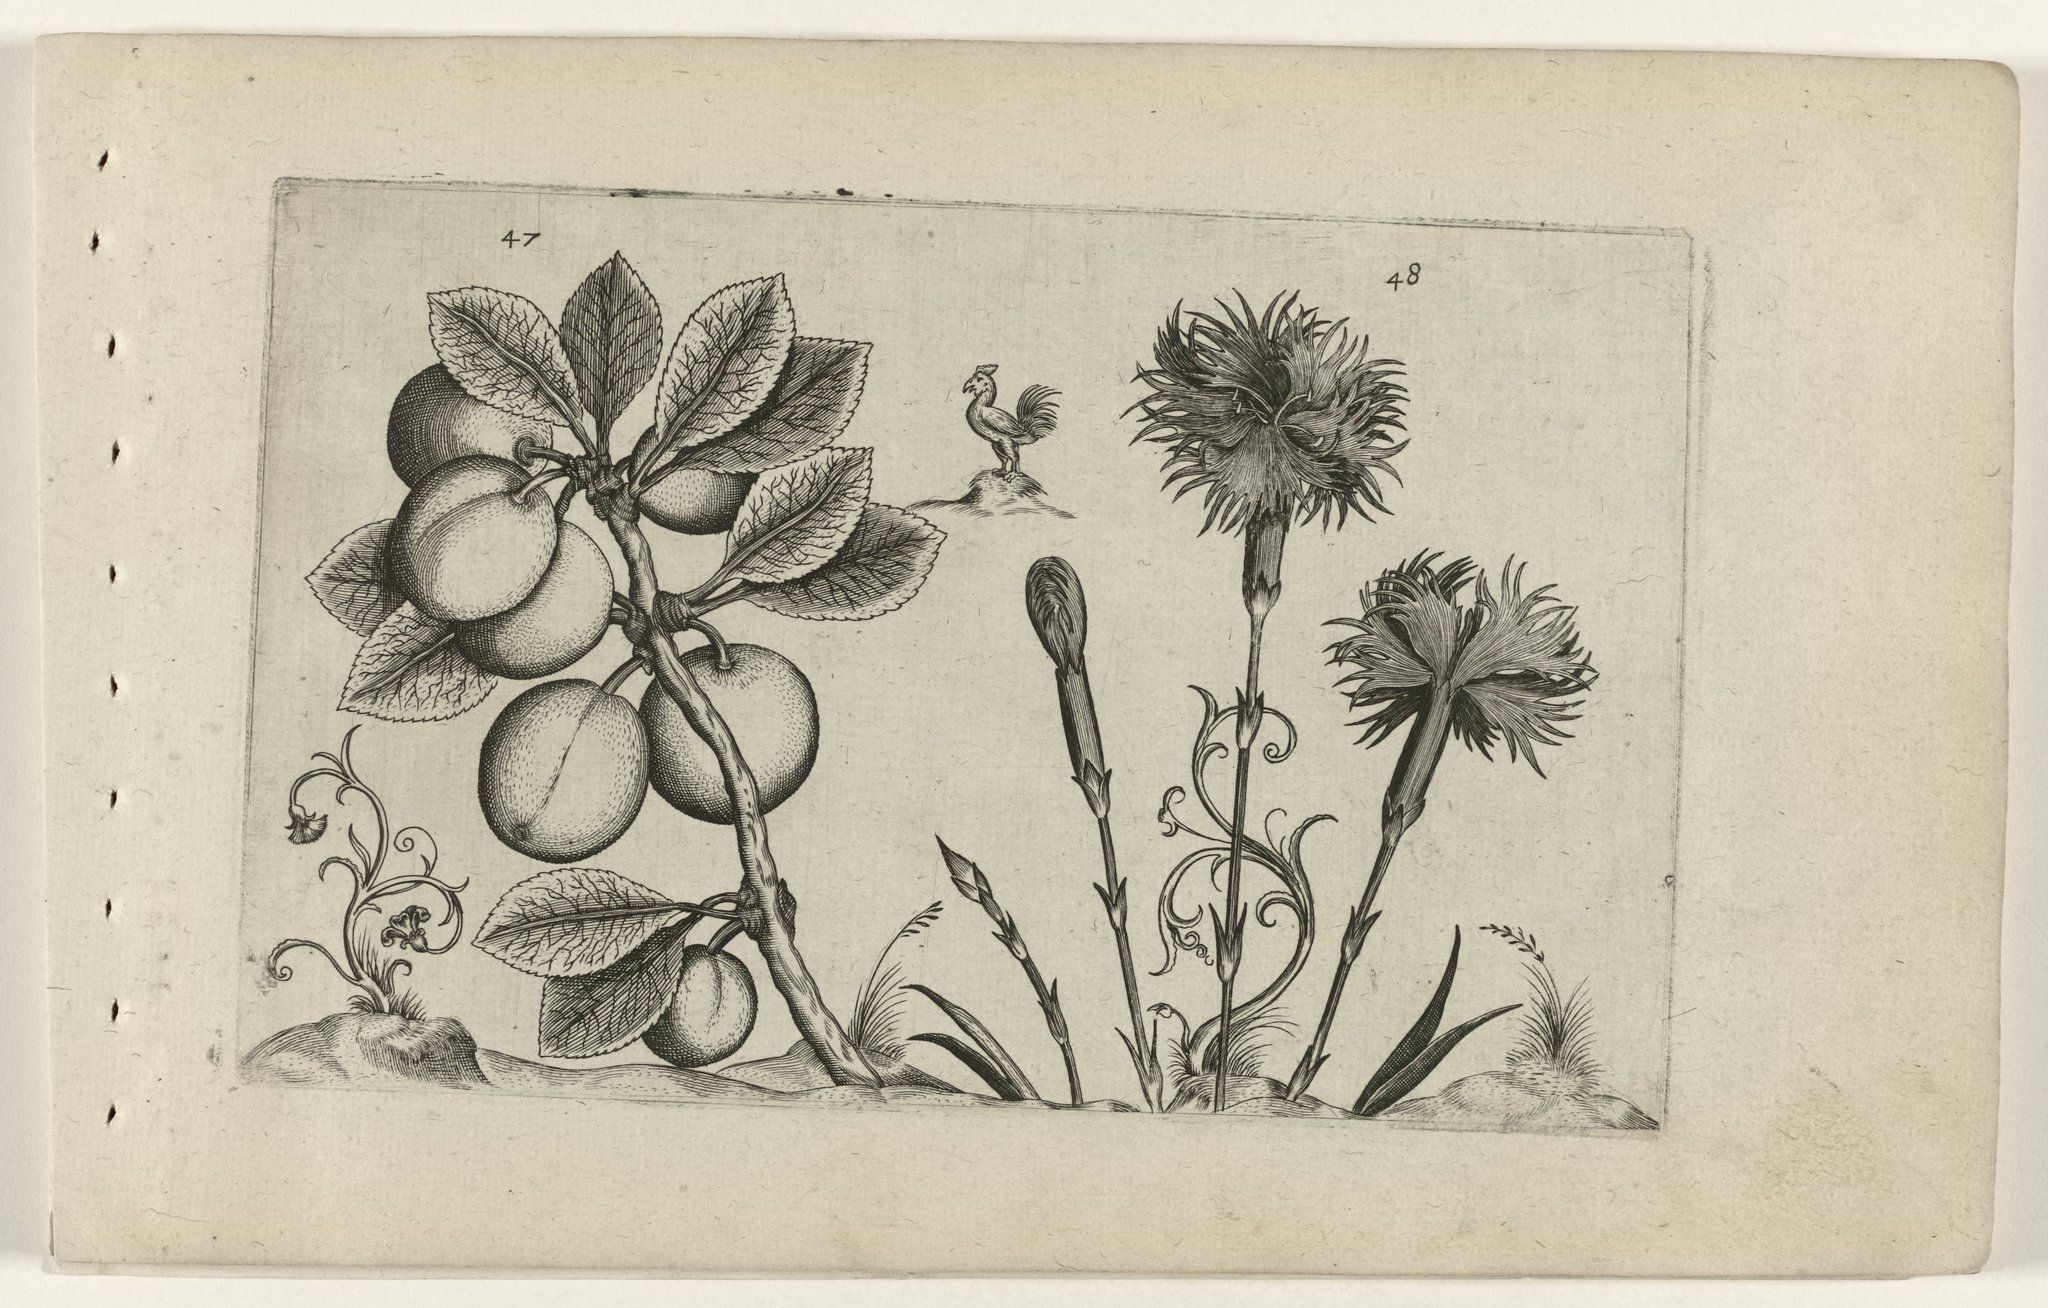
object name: album leaf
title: Kerspruim en tuinanjer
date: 1600-1604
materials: paper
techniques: engraving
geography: london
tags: fruits: cherry plum, botany, flowers: carnation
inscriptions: collector's mark: Lugt 2228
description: De prenten RP-P-2012-24-1 t/m 61 waren oorspronkelijk als serie samengebonden. De naaigaten op de bladen zijn nog zichtbaar. Het betreft de reeks getiteld: Cognoscite lilia, bestaande uit een titelprent en 60 gravures met 119 genummerde weergaven van planten, bloemen en vruchten, versierd met rinceaux en kleine voorstellingen van dieren. Het gaat om proefdrukken van deze reeks gravures, voor de opschriften en, deels, voor de nummering. Op enkele prenten zijn de nummers met de hand aangebracht. Op de titelprent ontbreekt nog het adres van Crispijn de Passe en Hans Woutneel. De titel is hoogstwaarschijnlijk gegraveerd door Matthias Quad. Deze werkte voor De Passe in Keulen tot 1604. De reeks moet in dit jaar of daarvoor tot stand zijn gebracht. In ieder geval voor 1608, aangezien de uitgever Hans Woutneel in of voor dat jaar overleed. In ieder geval voor 1608, aangezien de uitgever Hans Woutneel in of voor dat jaar overleed. De gravures worden door Ilja Veldman en Anthony Griffiths beschouwd als eigenhandig werk van Crispijn de Passe I. Een van de prenten uit de reeks ontbreekt (nr 21-22) en is vervangen door een ingekleurde afdruk uit een latere uitgave (RP-P-2012-24-61), die onder de titel Altera Pars is opgenomen in de Hortus Floridus, uitgegeven door Crispijn de Passe I en die verder bestaat uit platen van Crispijn de Passe II. De prenten afkomstig uit deze uitgave zijn op de verso voorzien van tekst in boekdruk. De vervangende prent maakte geen deel uit van de gebonden serie aangezien dit blad als enige geen naaigaten heeft. Een deel van de planten, bloemen en vruchten in de Cognoscite lilia gaat terug of is gebaseerd op een reeks aquarellen van Jacques LeMoyne uit circa 1580 en uit 1585, nu in het Victoria and Albert Museum en de British Museum (zie P. Hulton, Jacques LeMoyne, Londen 1977, dl 1, p. 156-162 en p. 165-173).